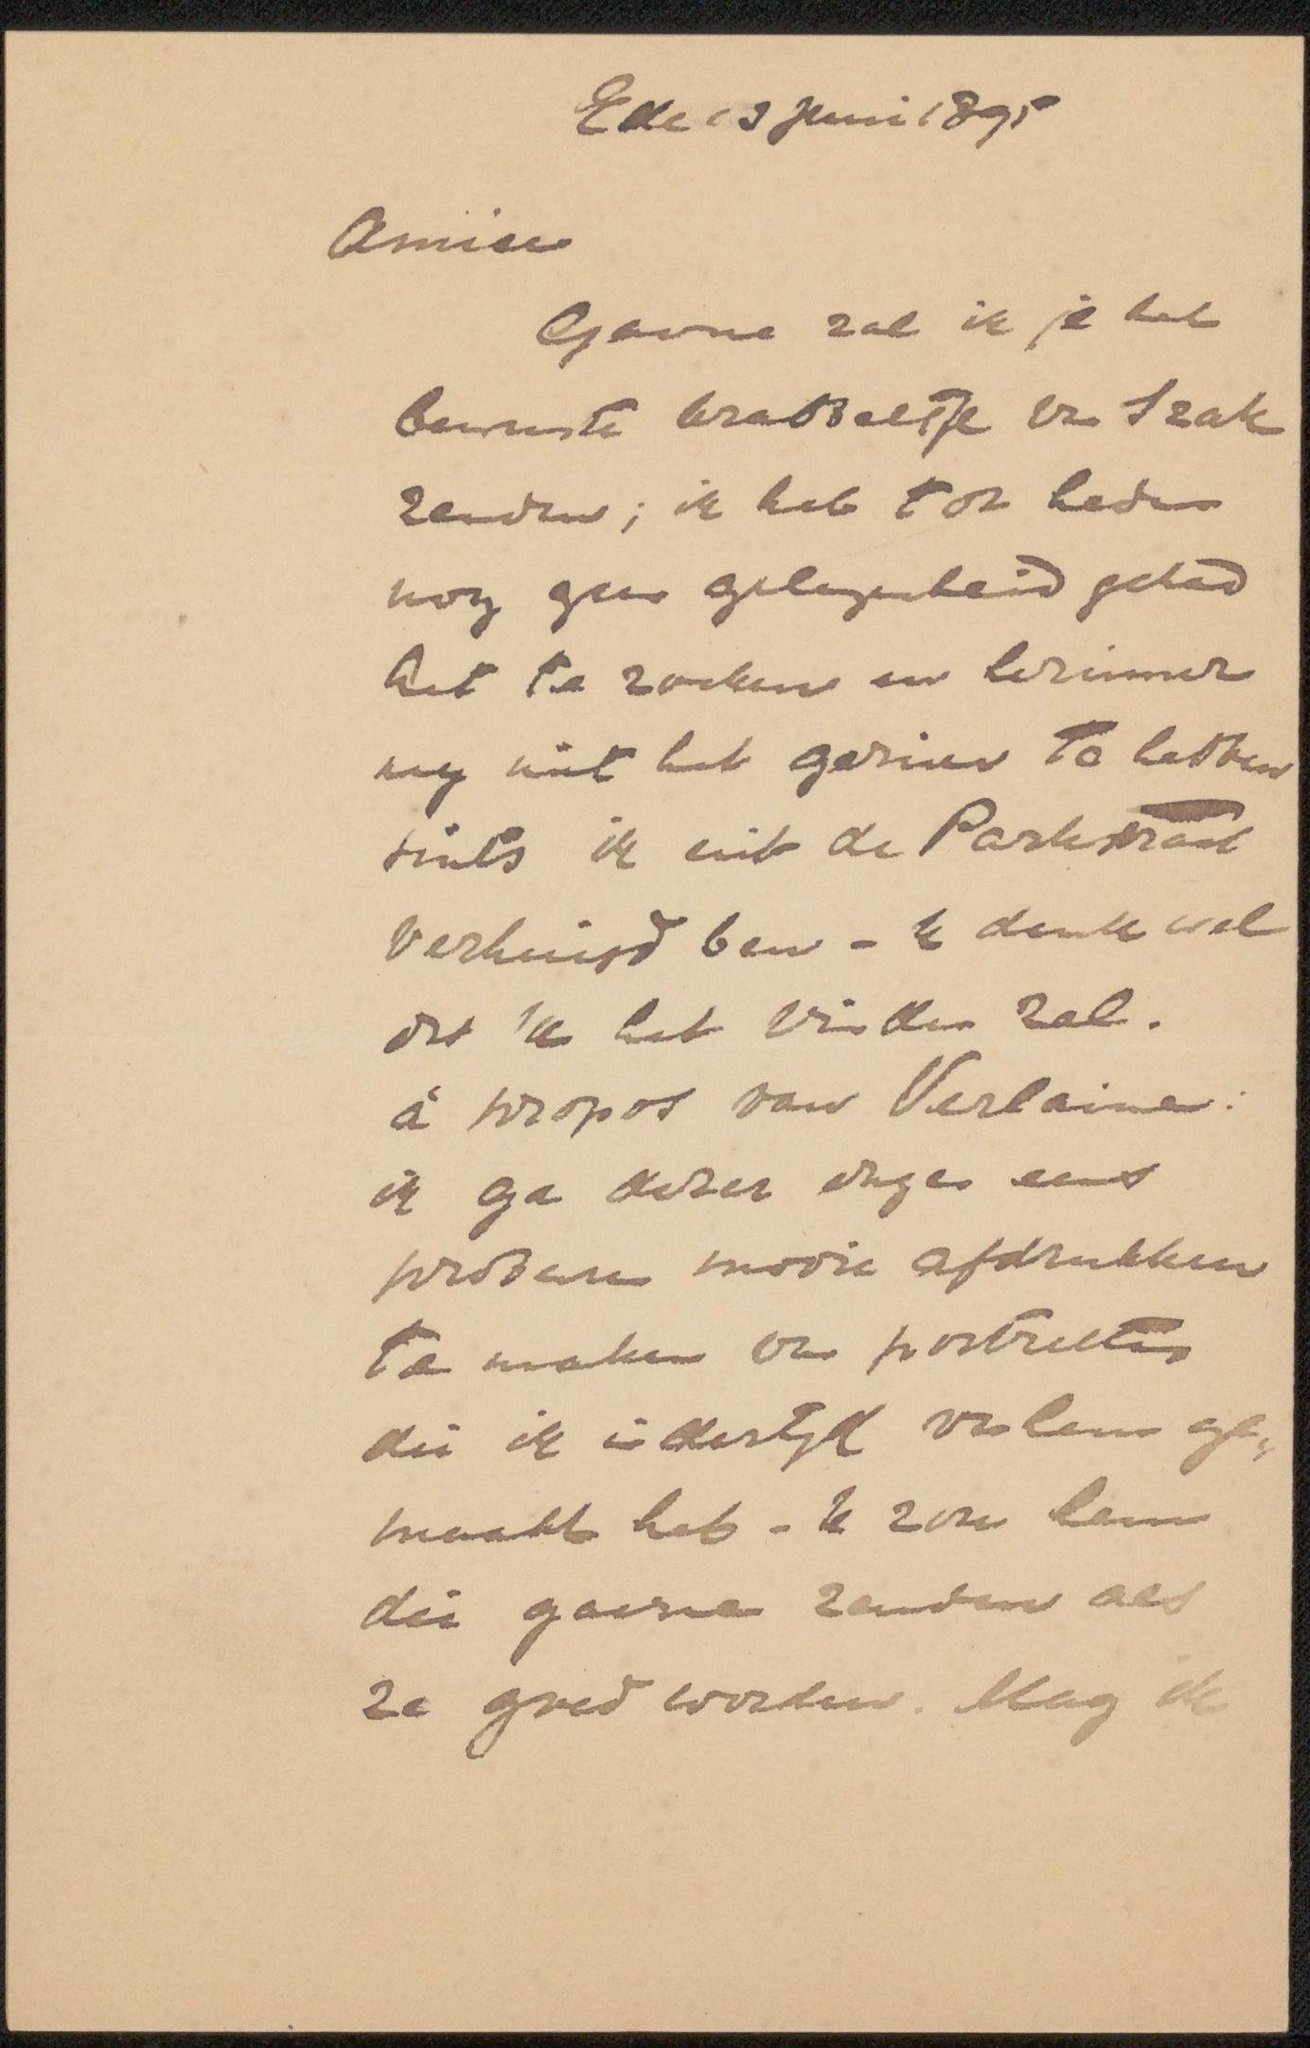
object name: letter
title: Brief aan Philip Zilcken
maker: willem witsen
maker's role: draughtsman, painter, print maker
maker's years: 1860-1923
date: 1895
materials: ink, paper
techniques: pen, writing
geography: ede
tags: paris, paul verlaine, philip zilcken, photography, cinematography, historical persons (portraits and scenes from the life), amsterdam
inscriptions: collector's mark: ‘RPK’, watermark